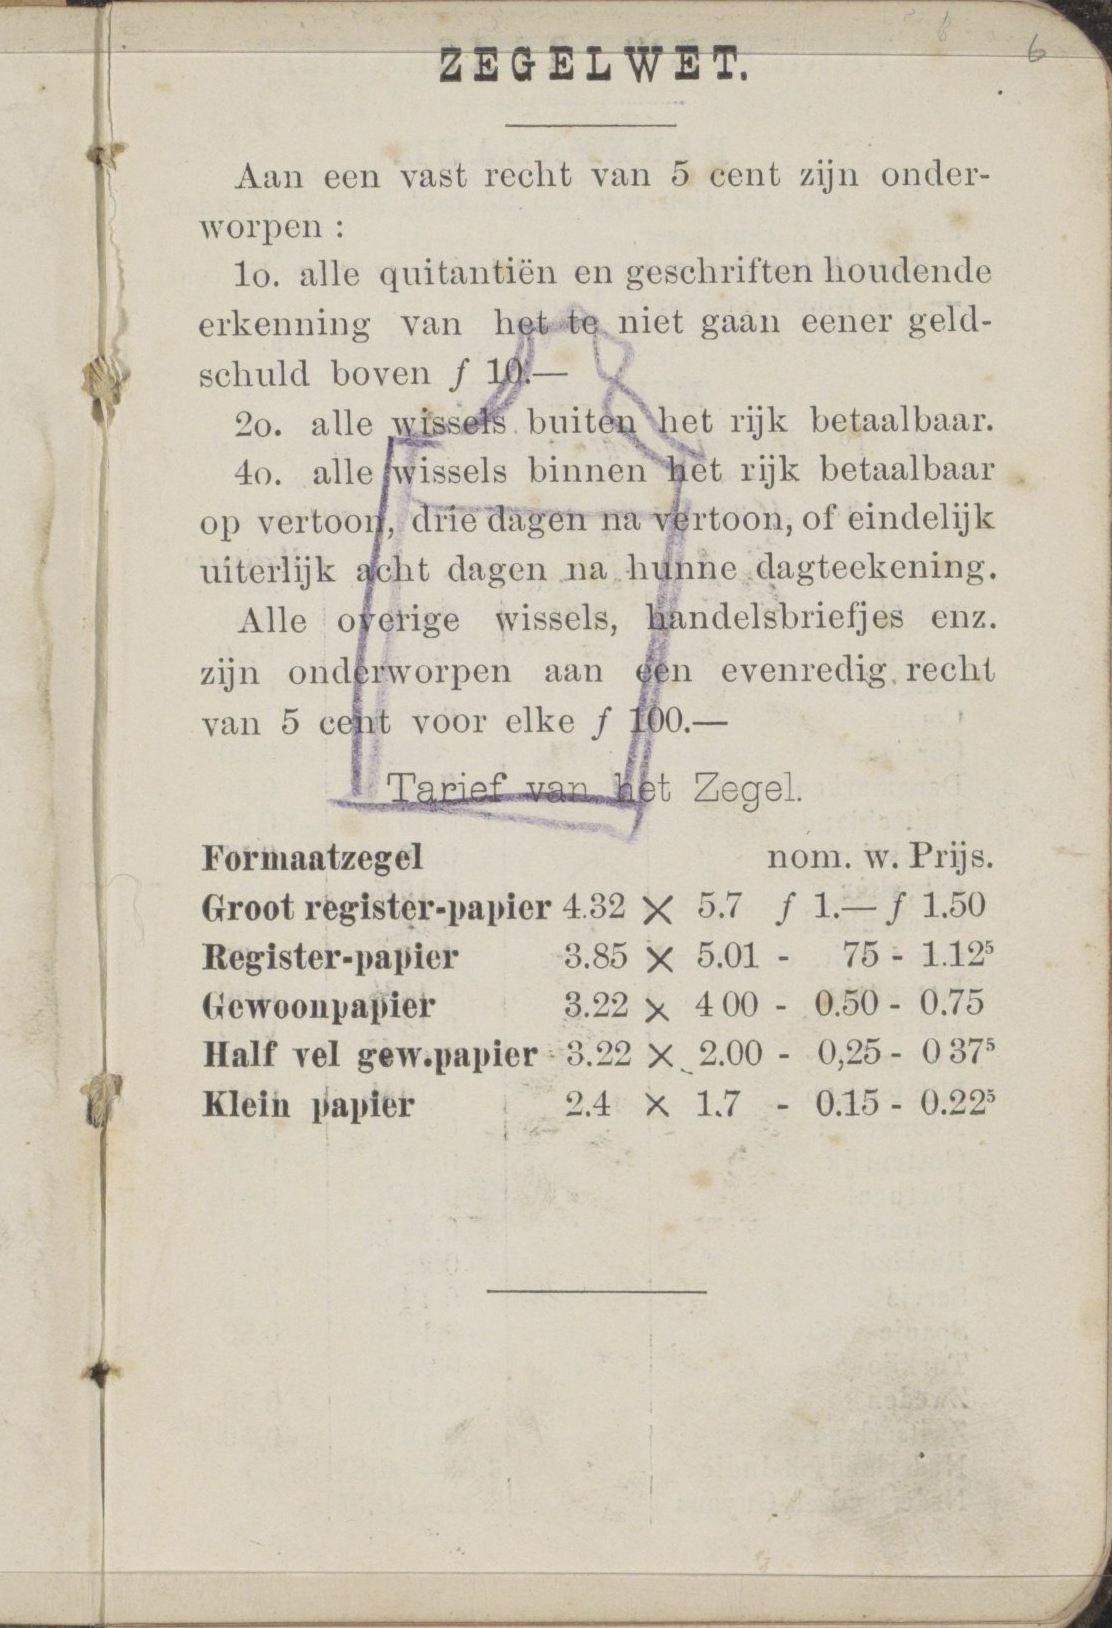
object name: sketchbook leaf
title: Gevel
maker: george hendrik breitner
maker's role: draughtsman, painter, print maker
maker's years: 1857-1923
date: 1893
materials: chalk, paper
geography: amsterdam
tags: façade (of house or building)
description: Pagina 6 uit een als schetsboek gebruikte agenda met 108 bladen.